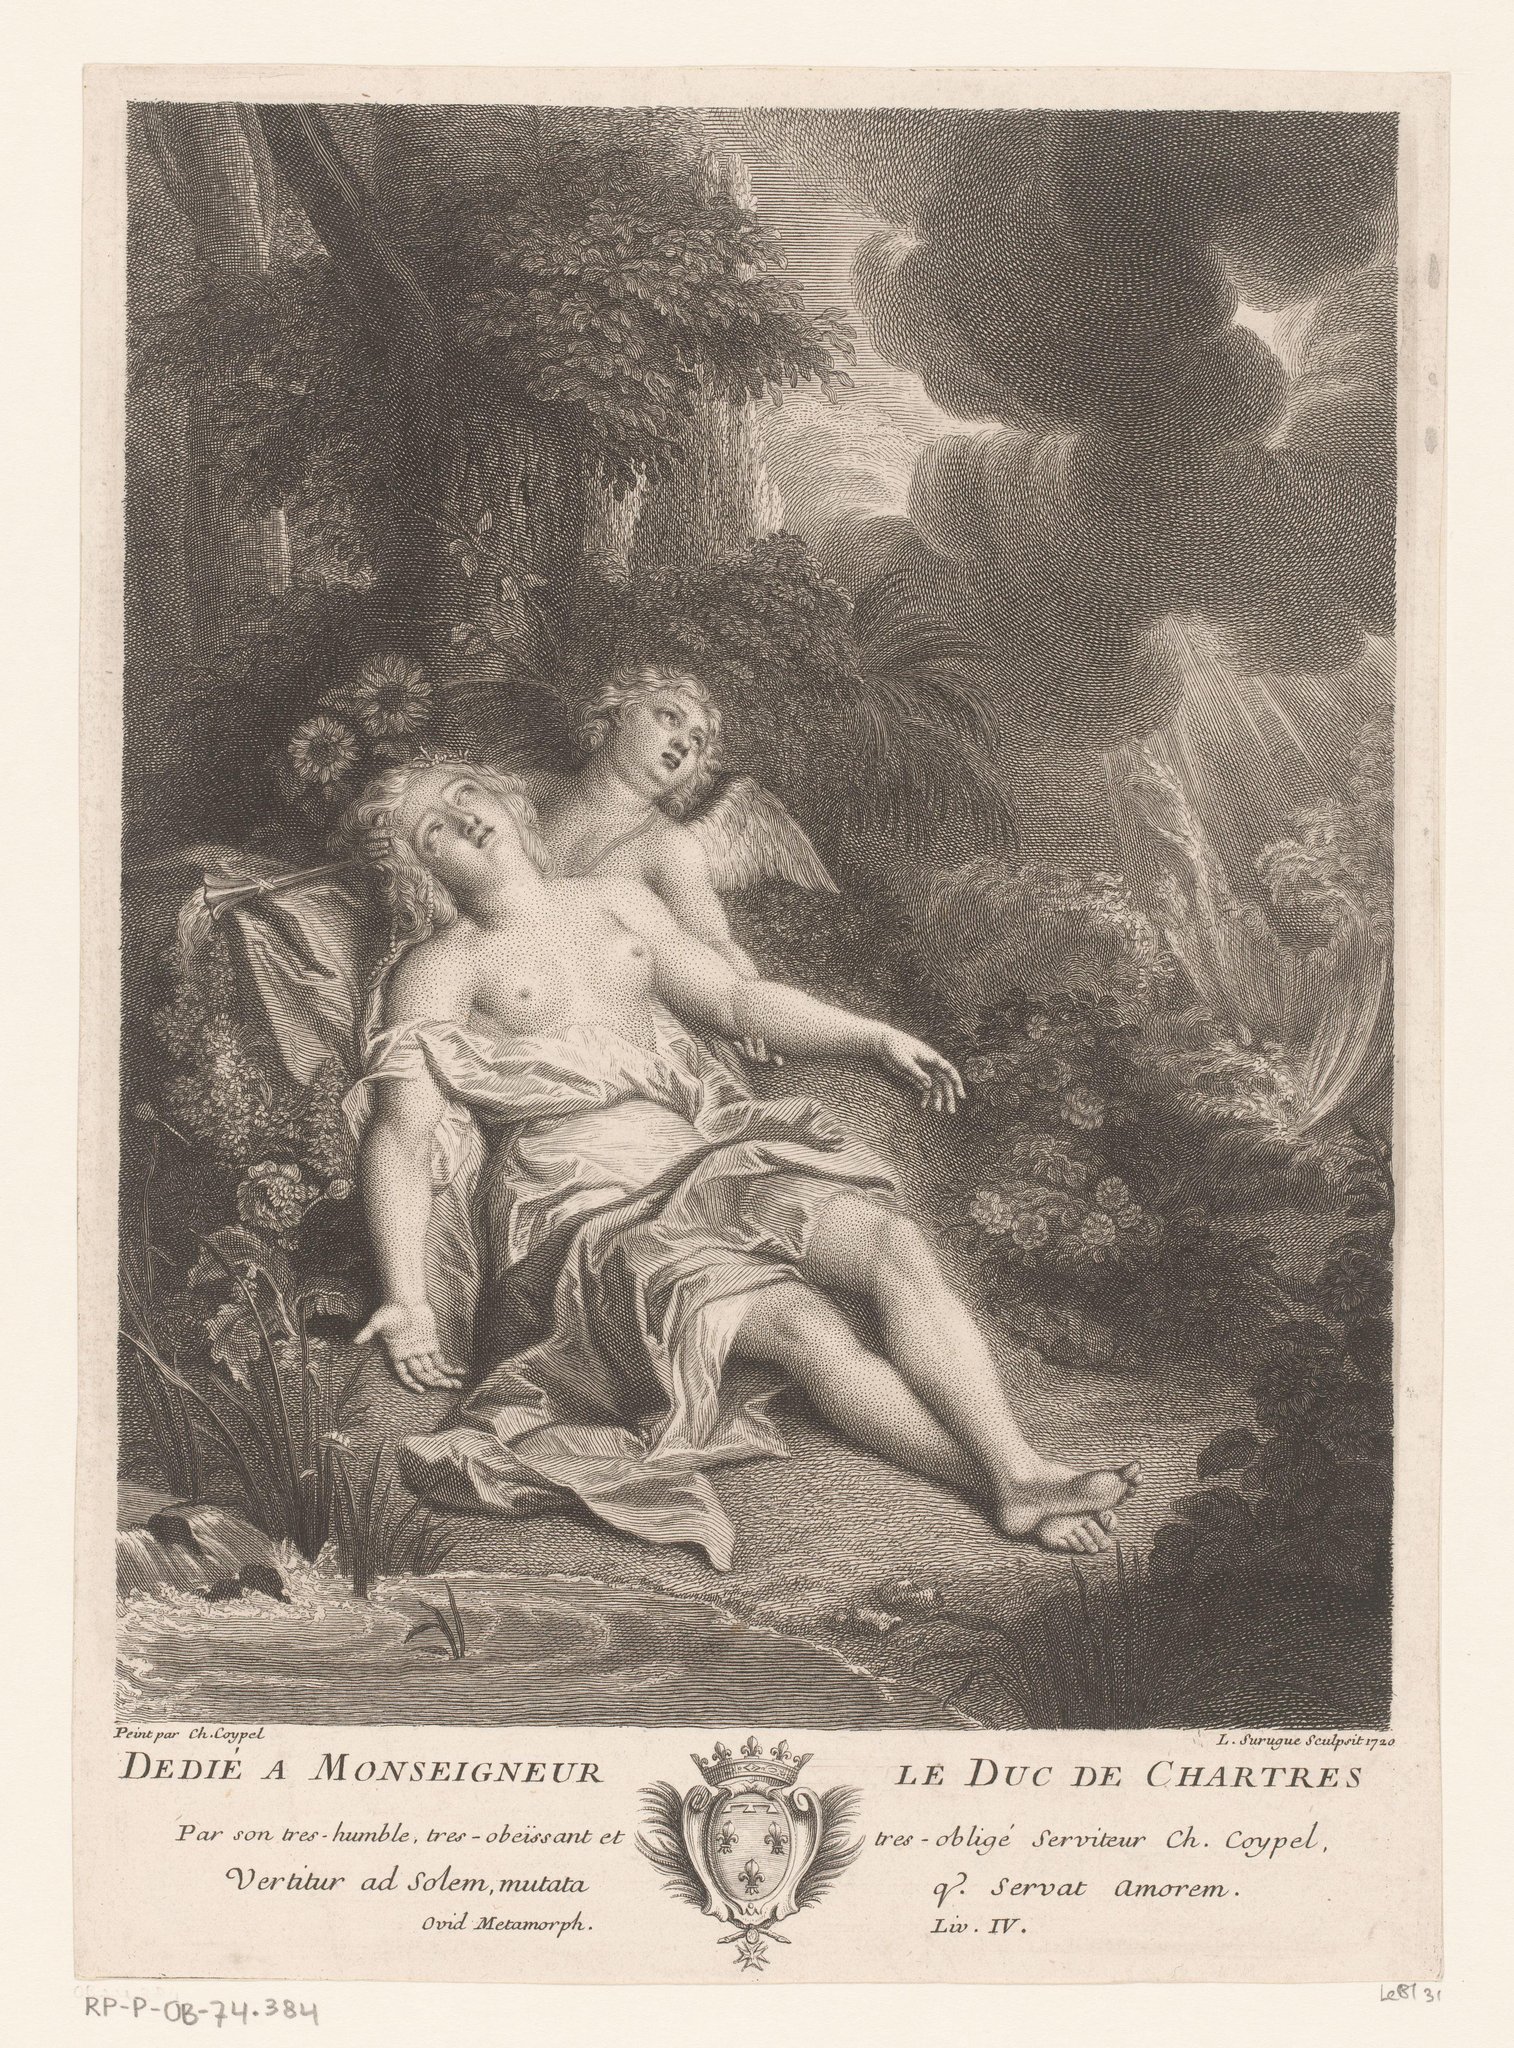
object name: print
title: Klytia wordt in een zonnebloem veranderd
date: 1720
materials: paper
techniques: engraving, etching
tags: flowers: sunflower, clytie changed into a sunflower: on account of apollo's contempt the oceanid clytie changes into a sunflower (heliotrope) (ovid, metamorphoses iv 268)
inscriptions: collector's mark: Lugt 240